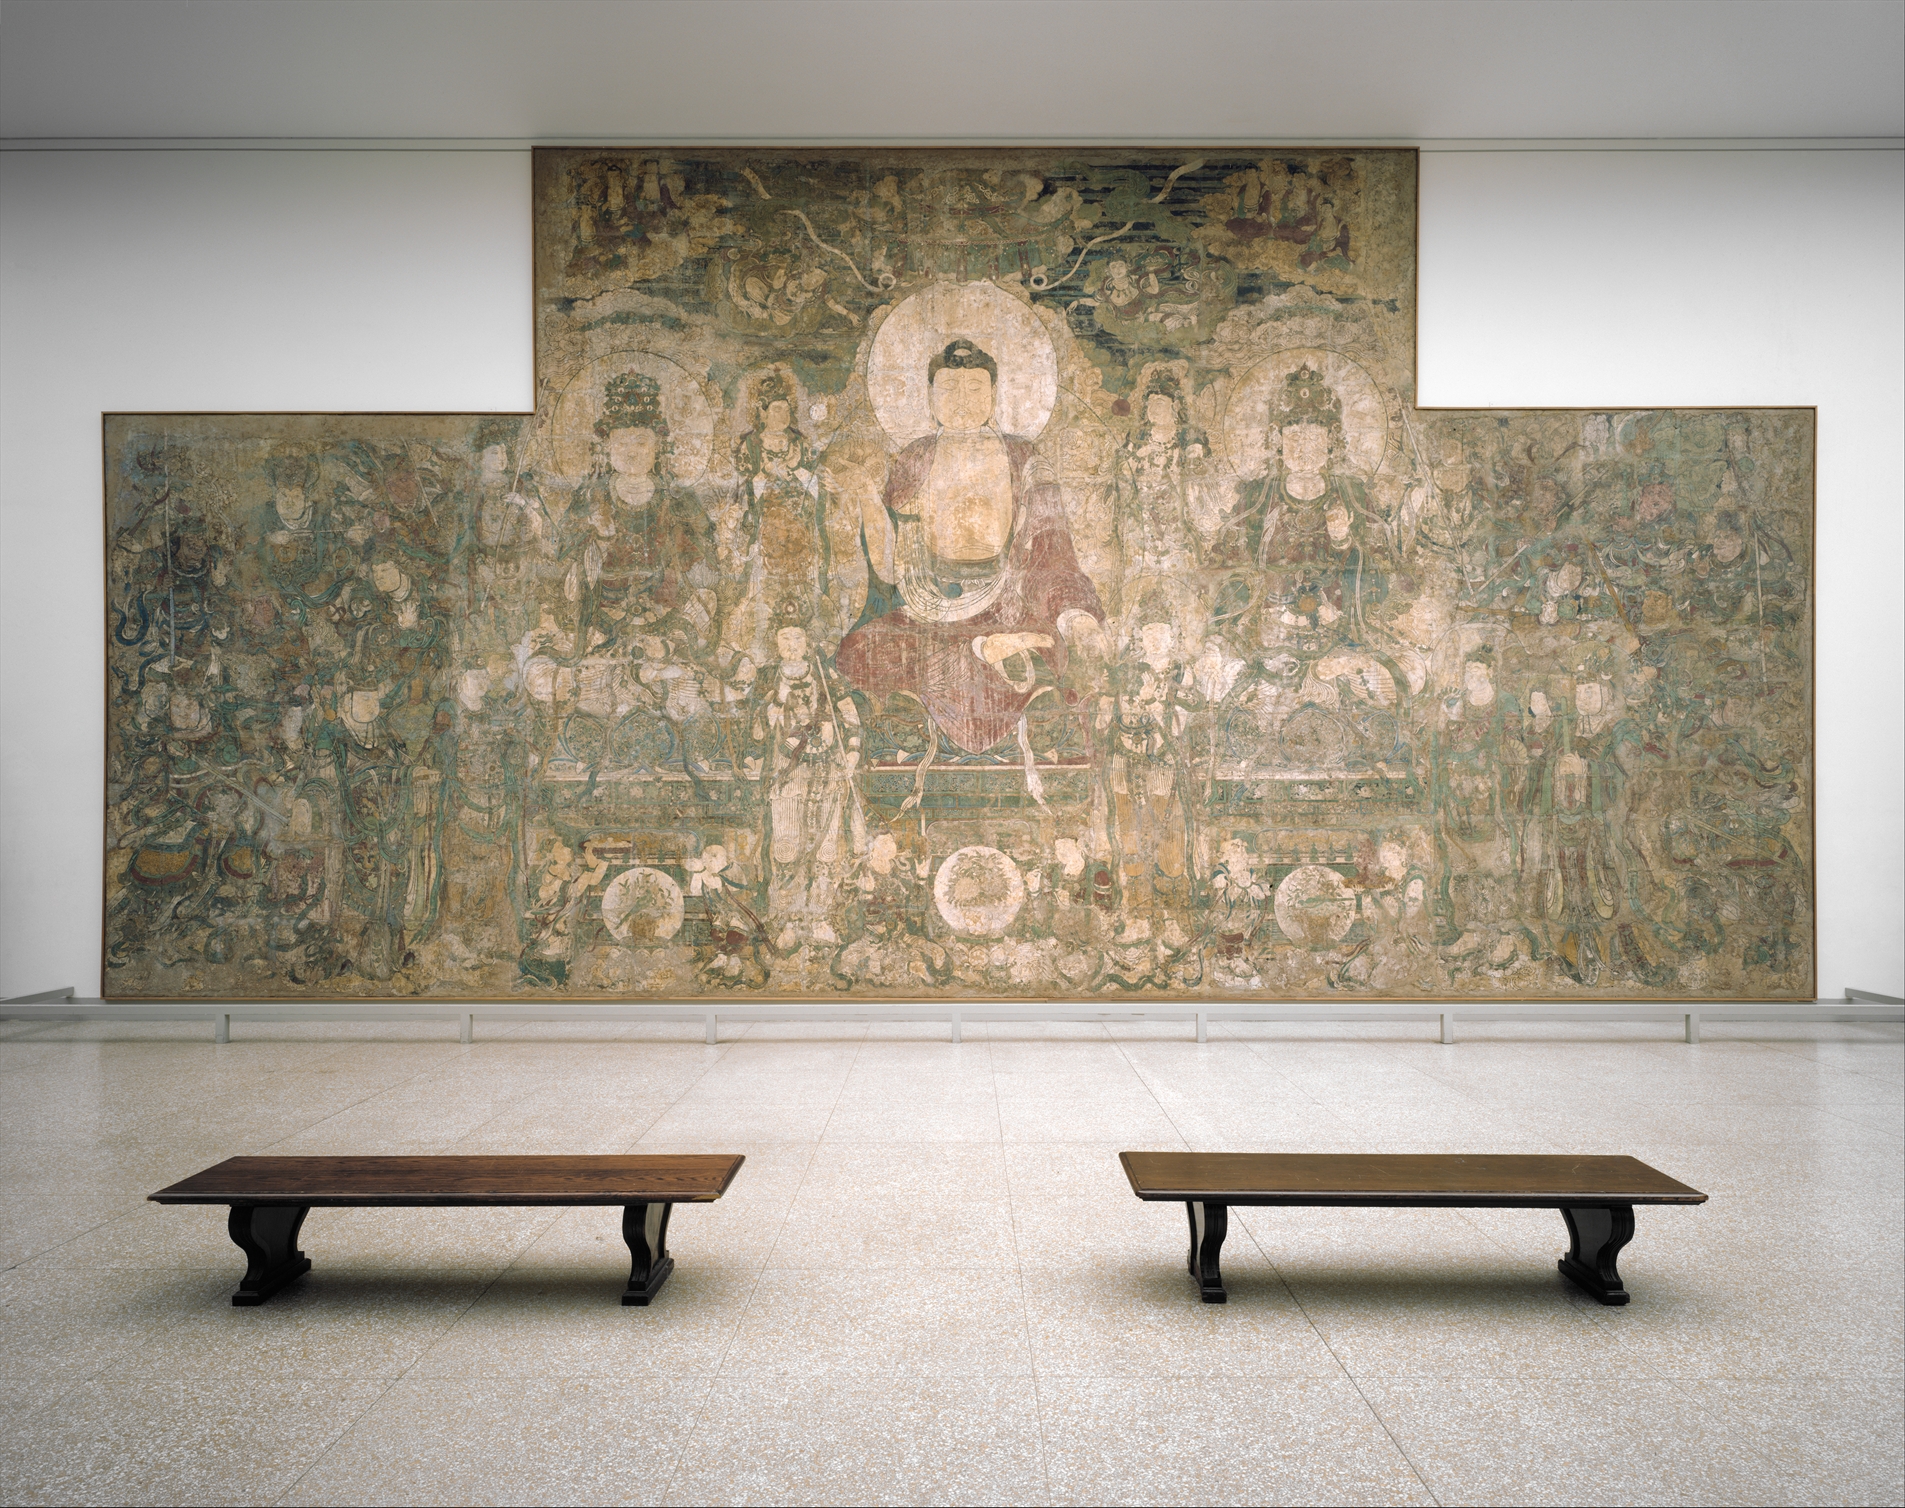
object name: wall painting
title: Buddha of Medicine Bhaishajyaguru (Yaoshi fo)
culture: chinese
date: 1319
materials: clay, pigment, fiber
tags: buddhism,bodhisattvas,buddha,medicine